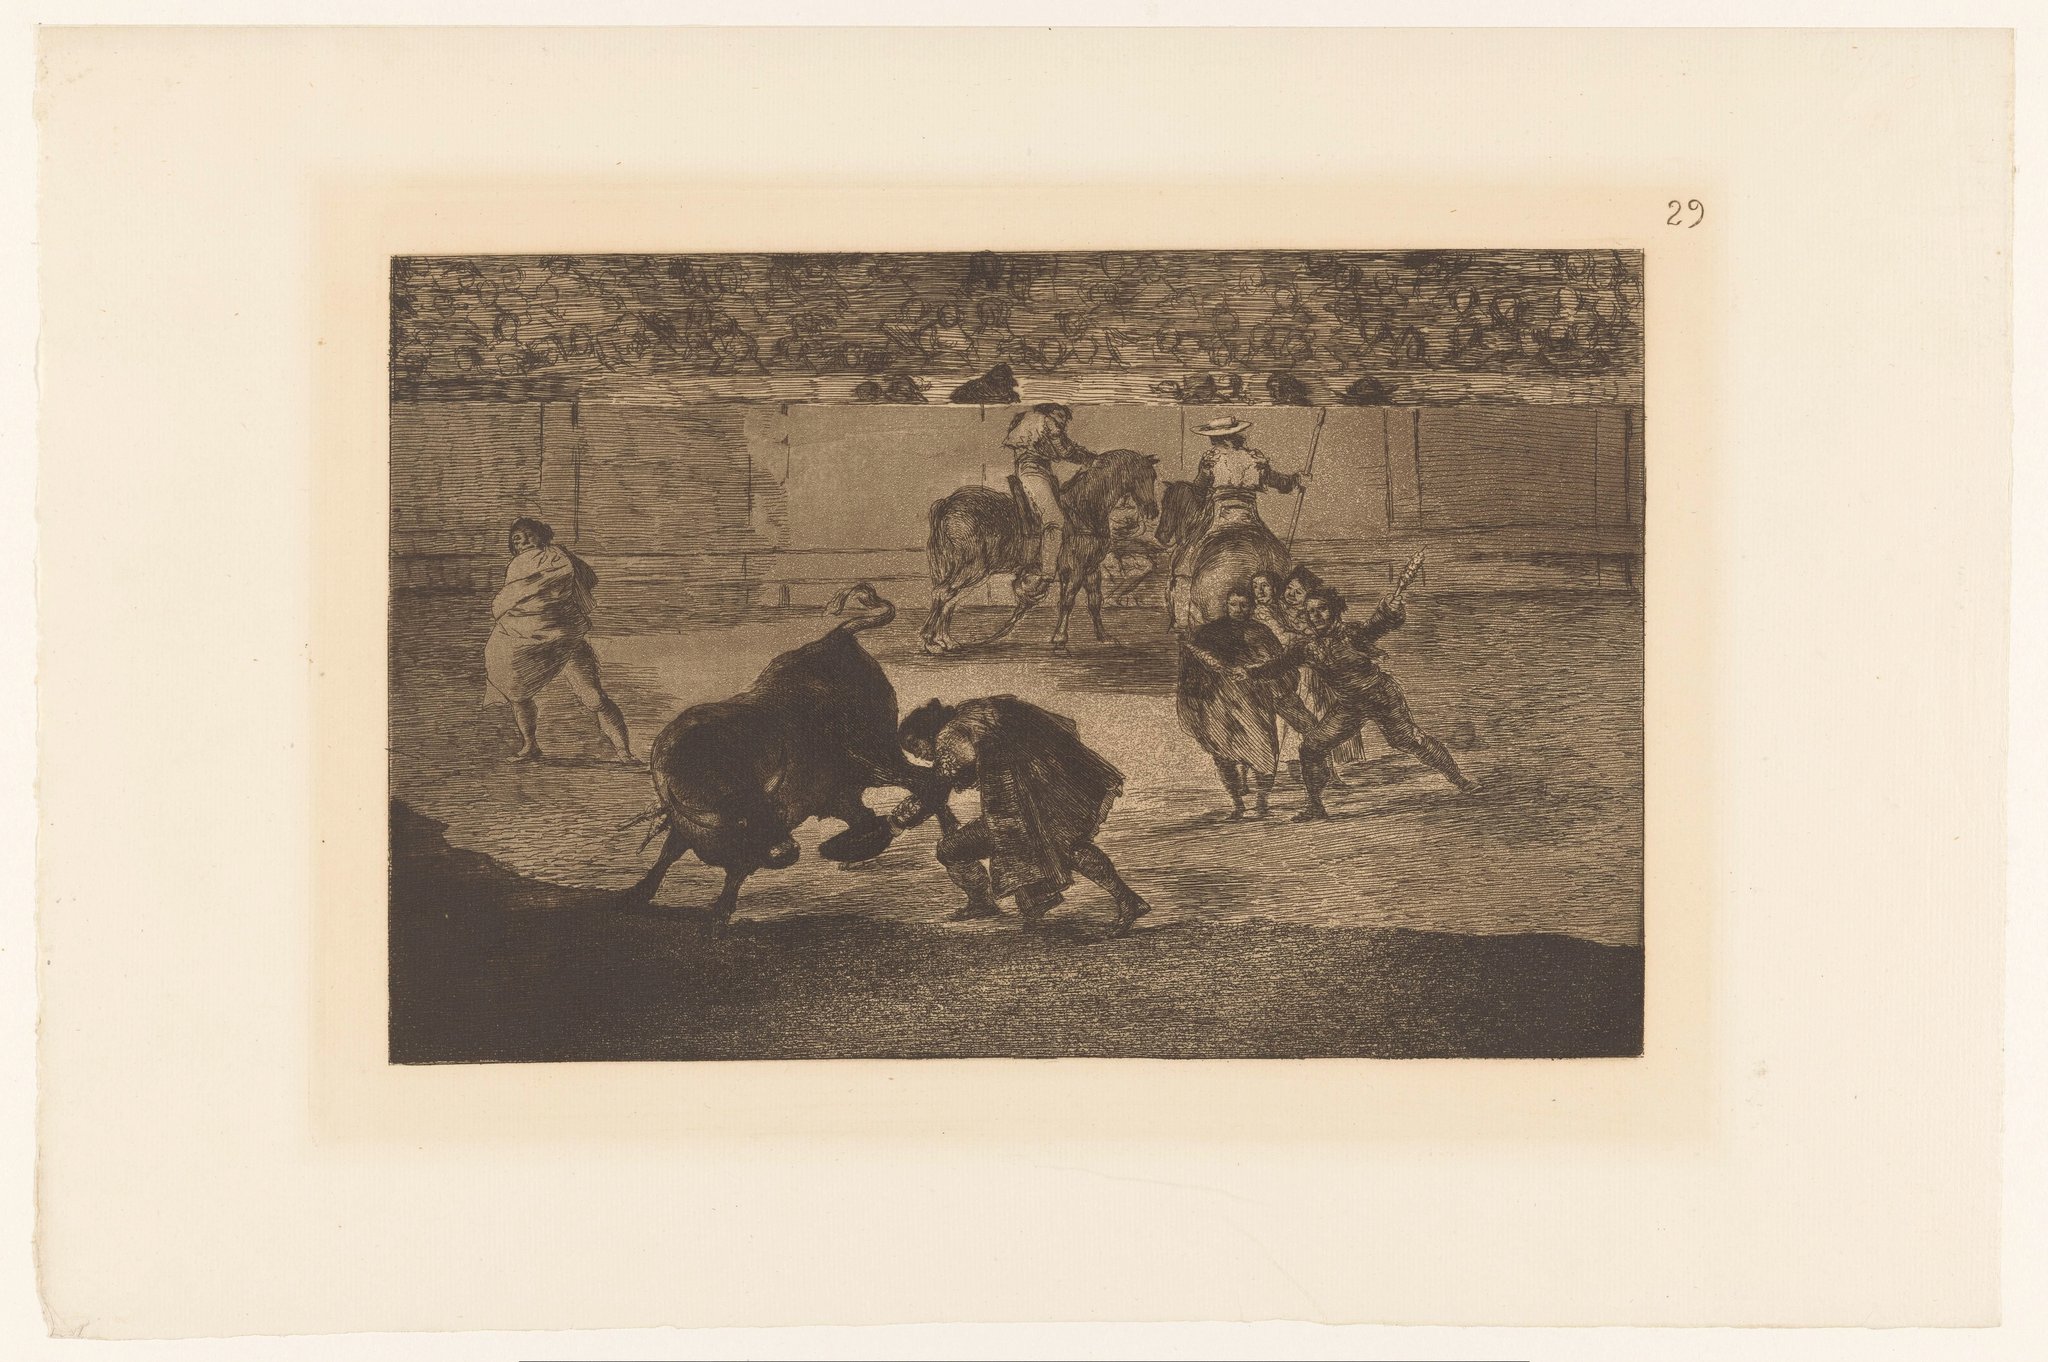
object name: print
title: Stierengevechten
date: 1876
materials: paper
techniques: aquatint, etching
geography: spain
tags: sevilla, bullfight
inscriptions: collector's mark: Lugt 2228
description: Deze prent maakt deel uit van een serie van 40 prenten door Francisco de Goya met voorstellingen van stierengevechten. De eerste editie bestond uit 33 genummerde prenten en werd uitgegeven in 1816. Dit betreft de derde editie, uitgegeven in 1876 door Eugène Loizelet en door hem voorzien van een titelprent en lijst met titels. Naast de 33 prenten publiceerde Loizelet ook de prenten die door Goya op de achterkanten van 7 van de platen werden geëtst. Deze zijn niet voorzien van nummers maar van de letters A-G.